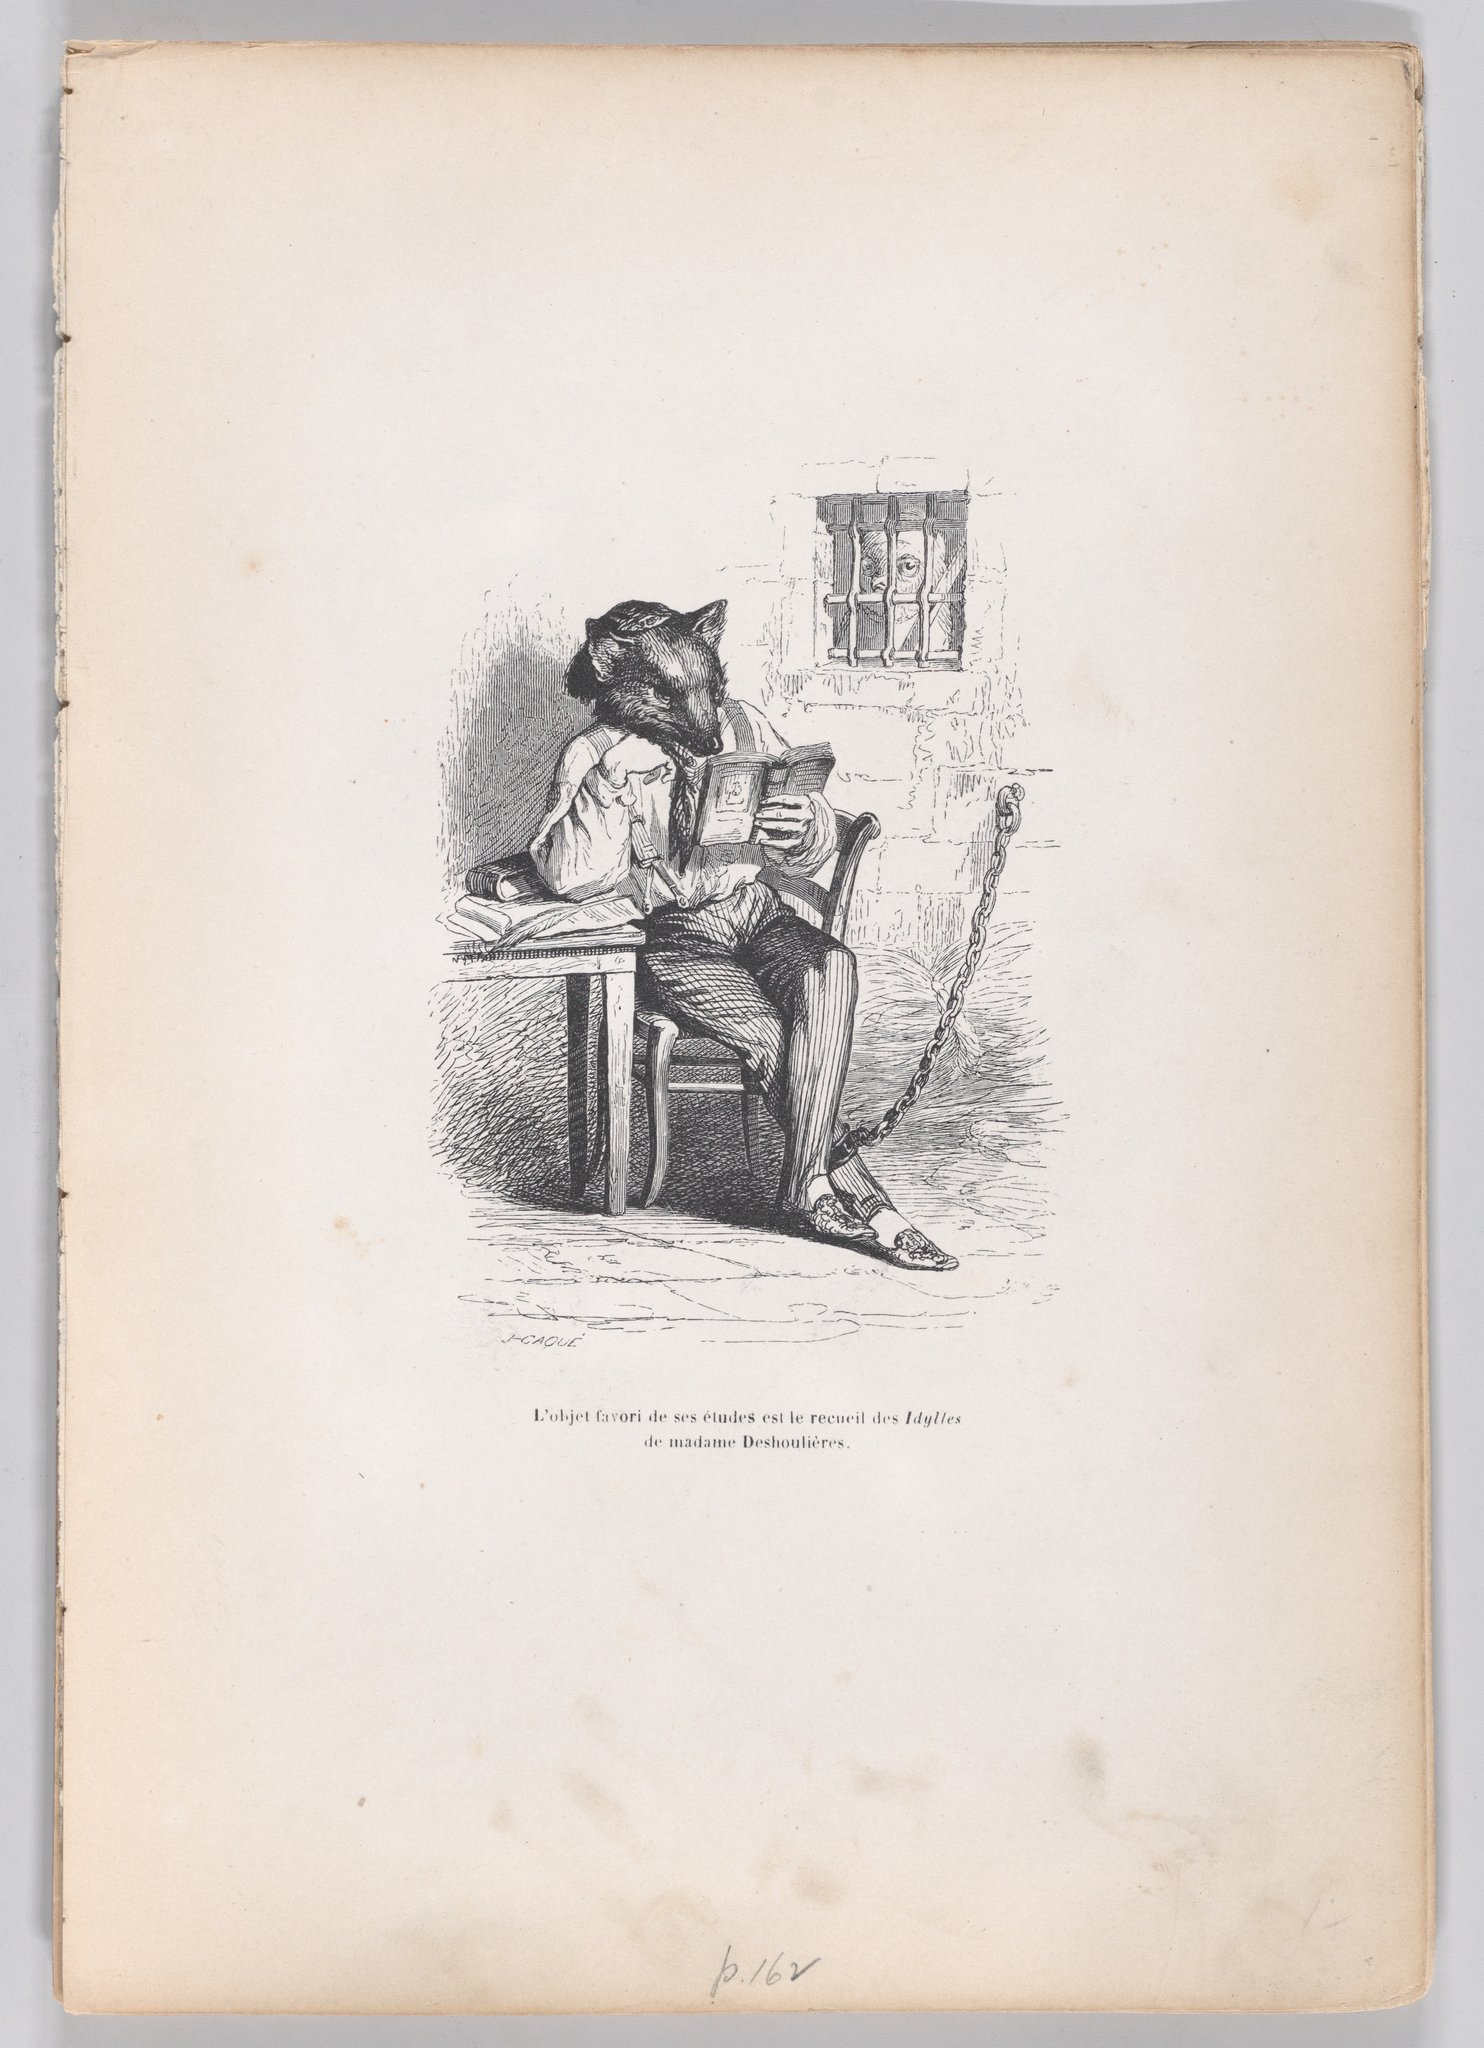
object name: print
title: The favorite object of his studies is the collection of Idylles by Madame Deshoulières, from "Scenes from the Private and Public Life of Animals"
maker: j. j. grandville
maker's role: illustrator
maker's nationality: french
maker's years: 1803-1847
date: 1837-1847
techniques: engraving